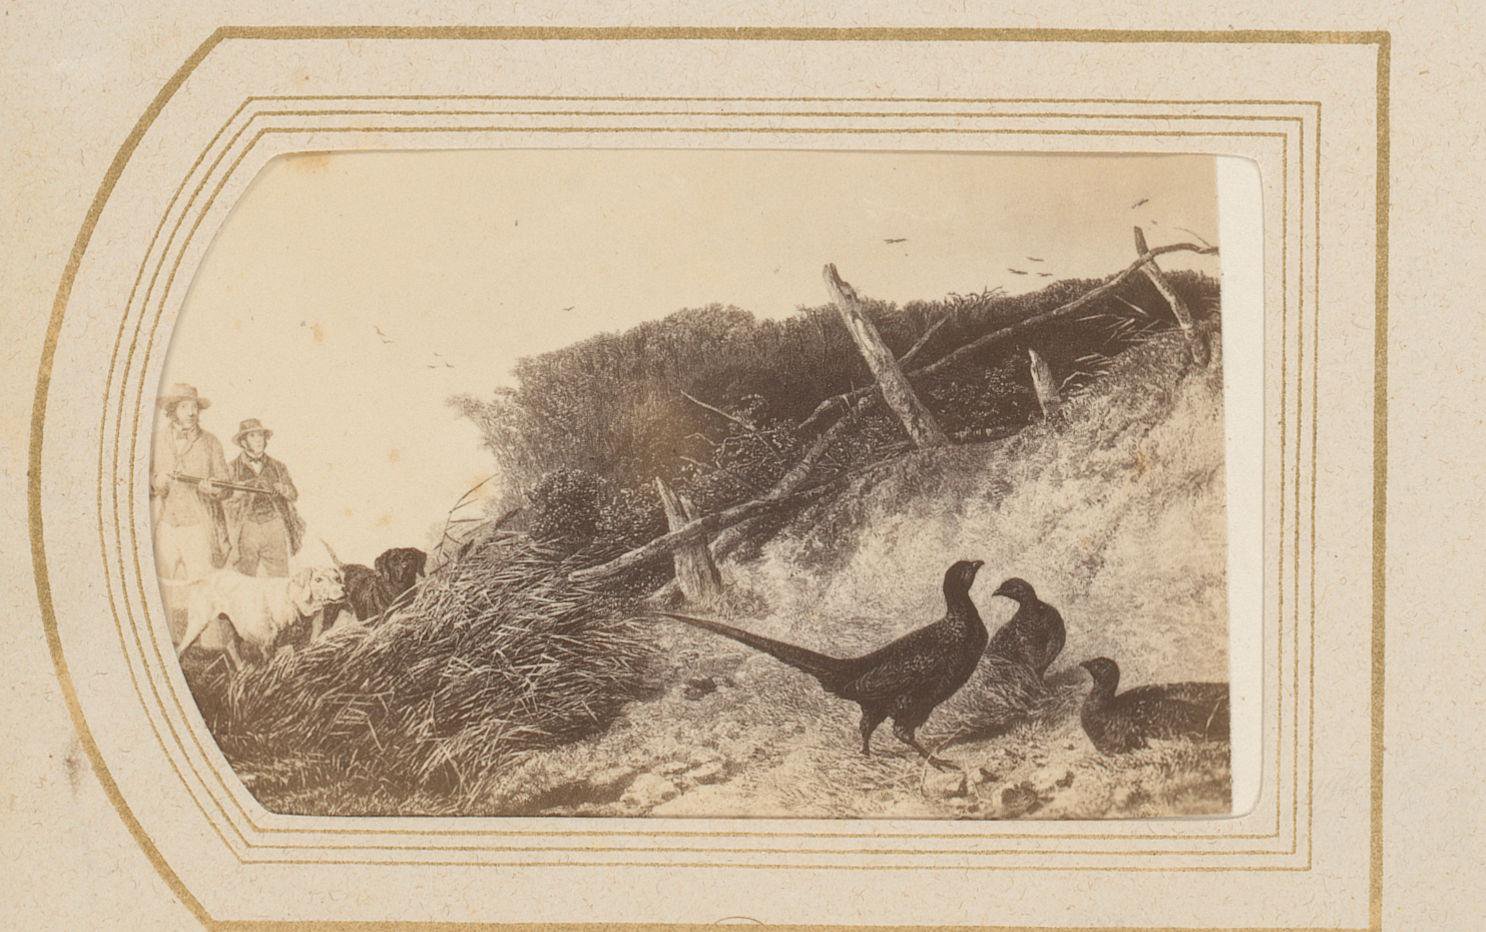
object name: reproduction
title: Fotoreproductie van Pheasant door Richard Ansdell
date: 1870-1900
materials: cardboard, photographic support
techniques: albumen print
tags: walker and runner birds: pheasant, dog, painting, drawing and the graphic arts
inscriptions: annotation: ‘Falanenjagd’, inscription: ‘1916./ Richard Ansdell./ Chasse au faisan./ Falanenjagd/ Pheadant.’